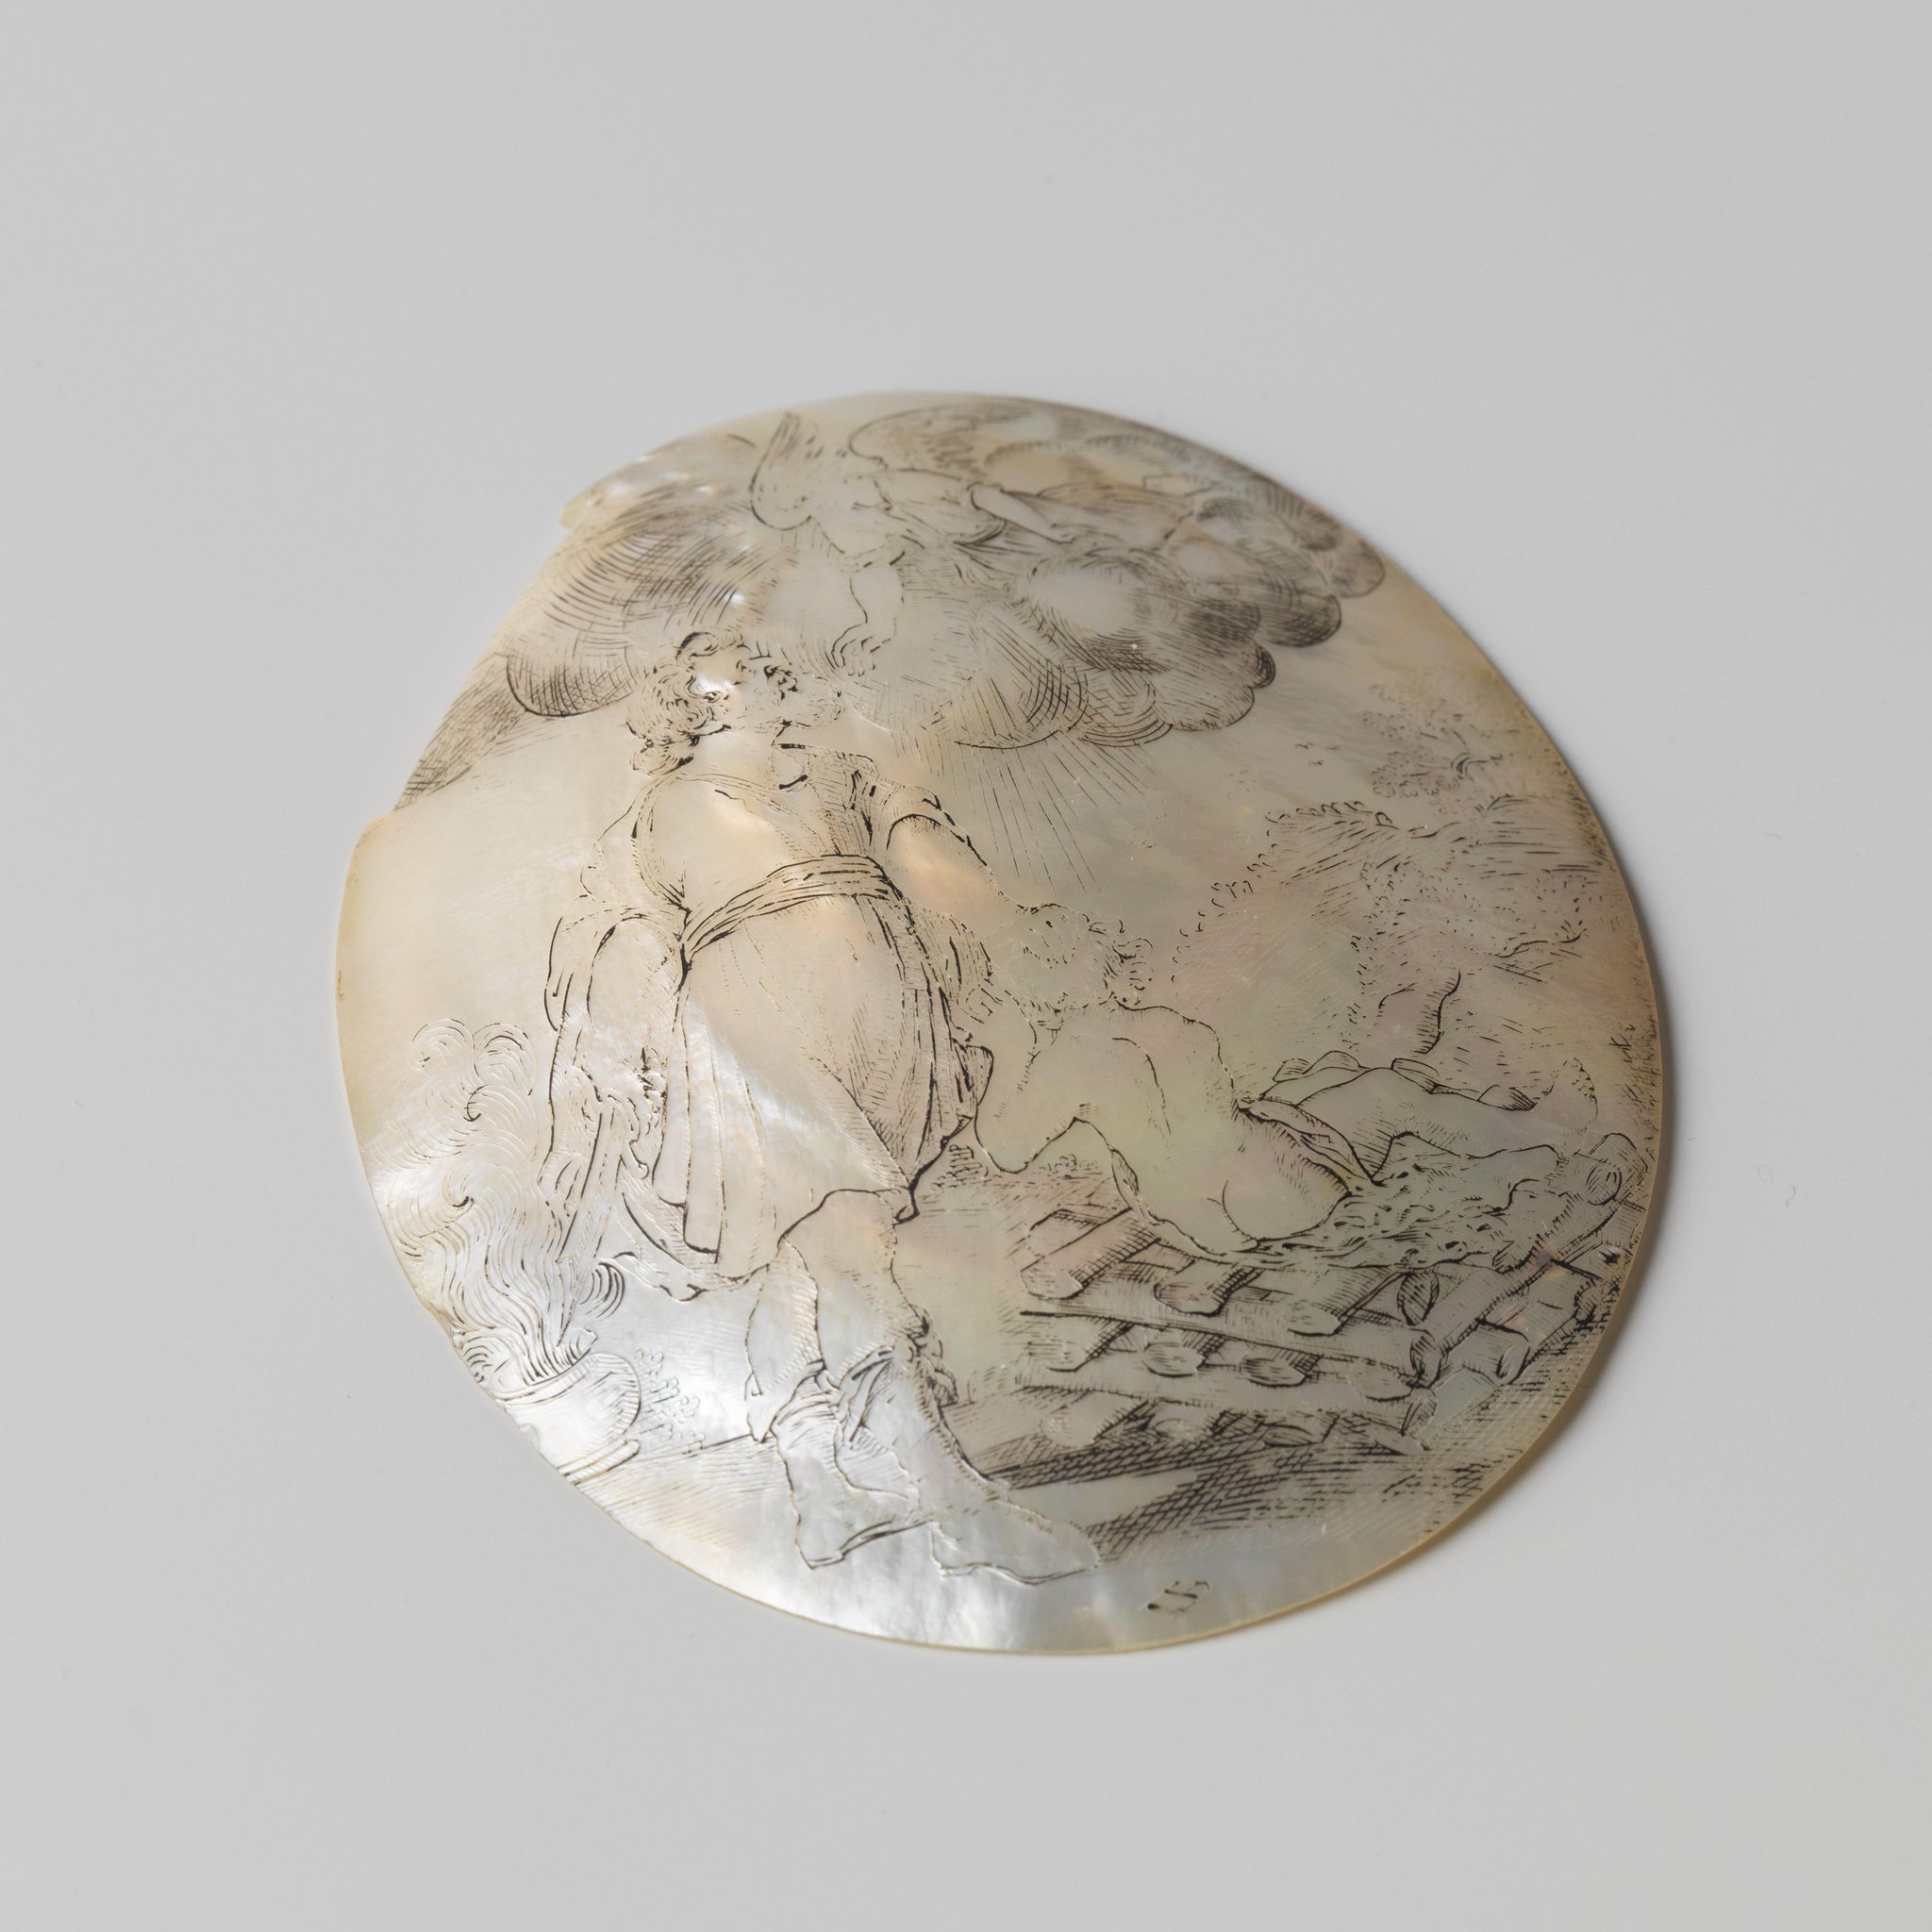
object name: plaque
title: Plaquette van oesterschelp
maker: jean bellekin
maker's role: paarlemoerwerker, parelmoerwerker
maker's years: 1597-1636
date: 1600-1699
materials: shell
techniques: engraving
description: Oesterschelp met gravure in parelmoer met de voorstelling van Abraham's offer. Gemerkt.